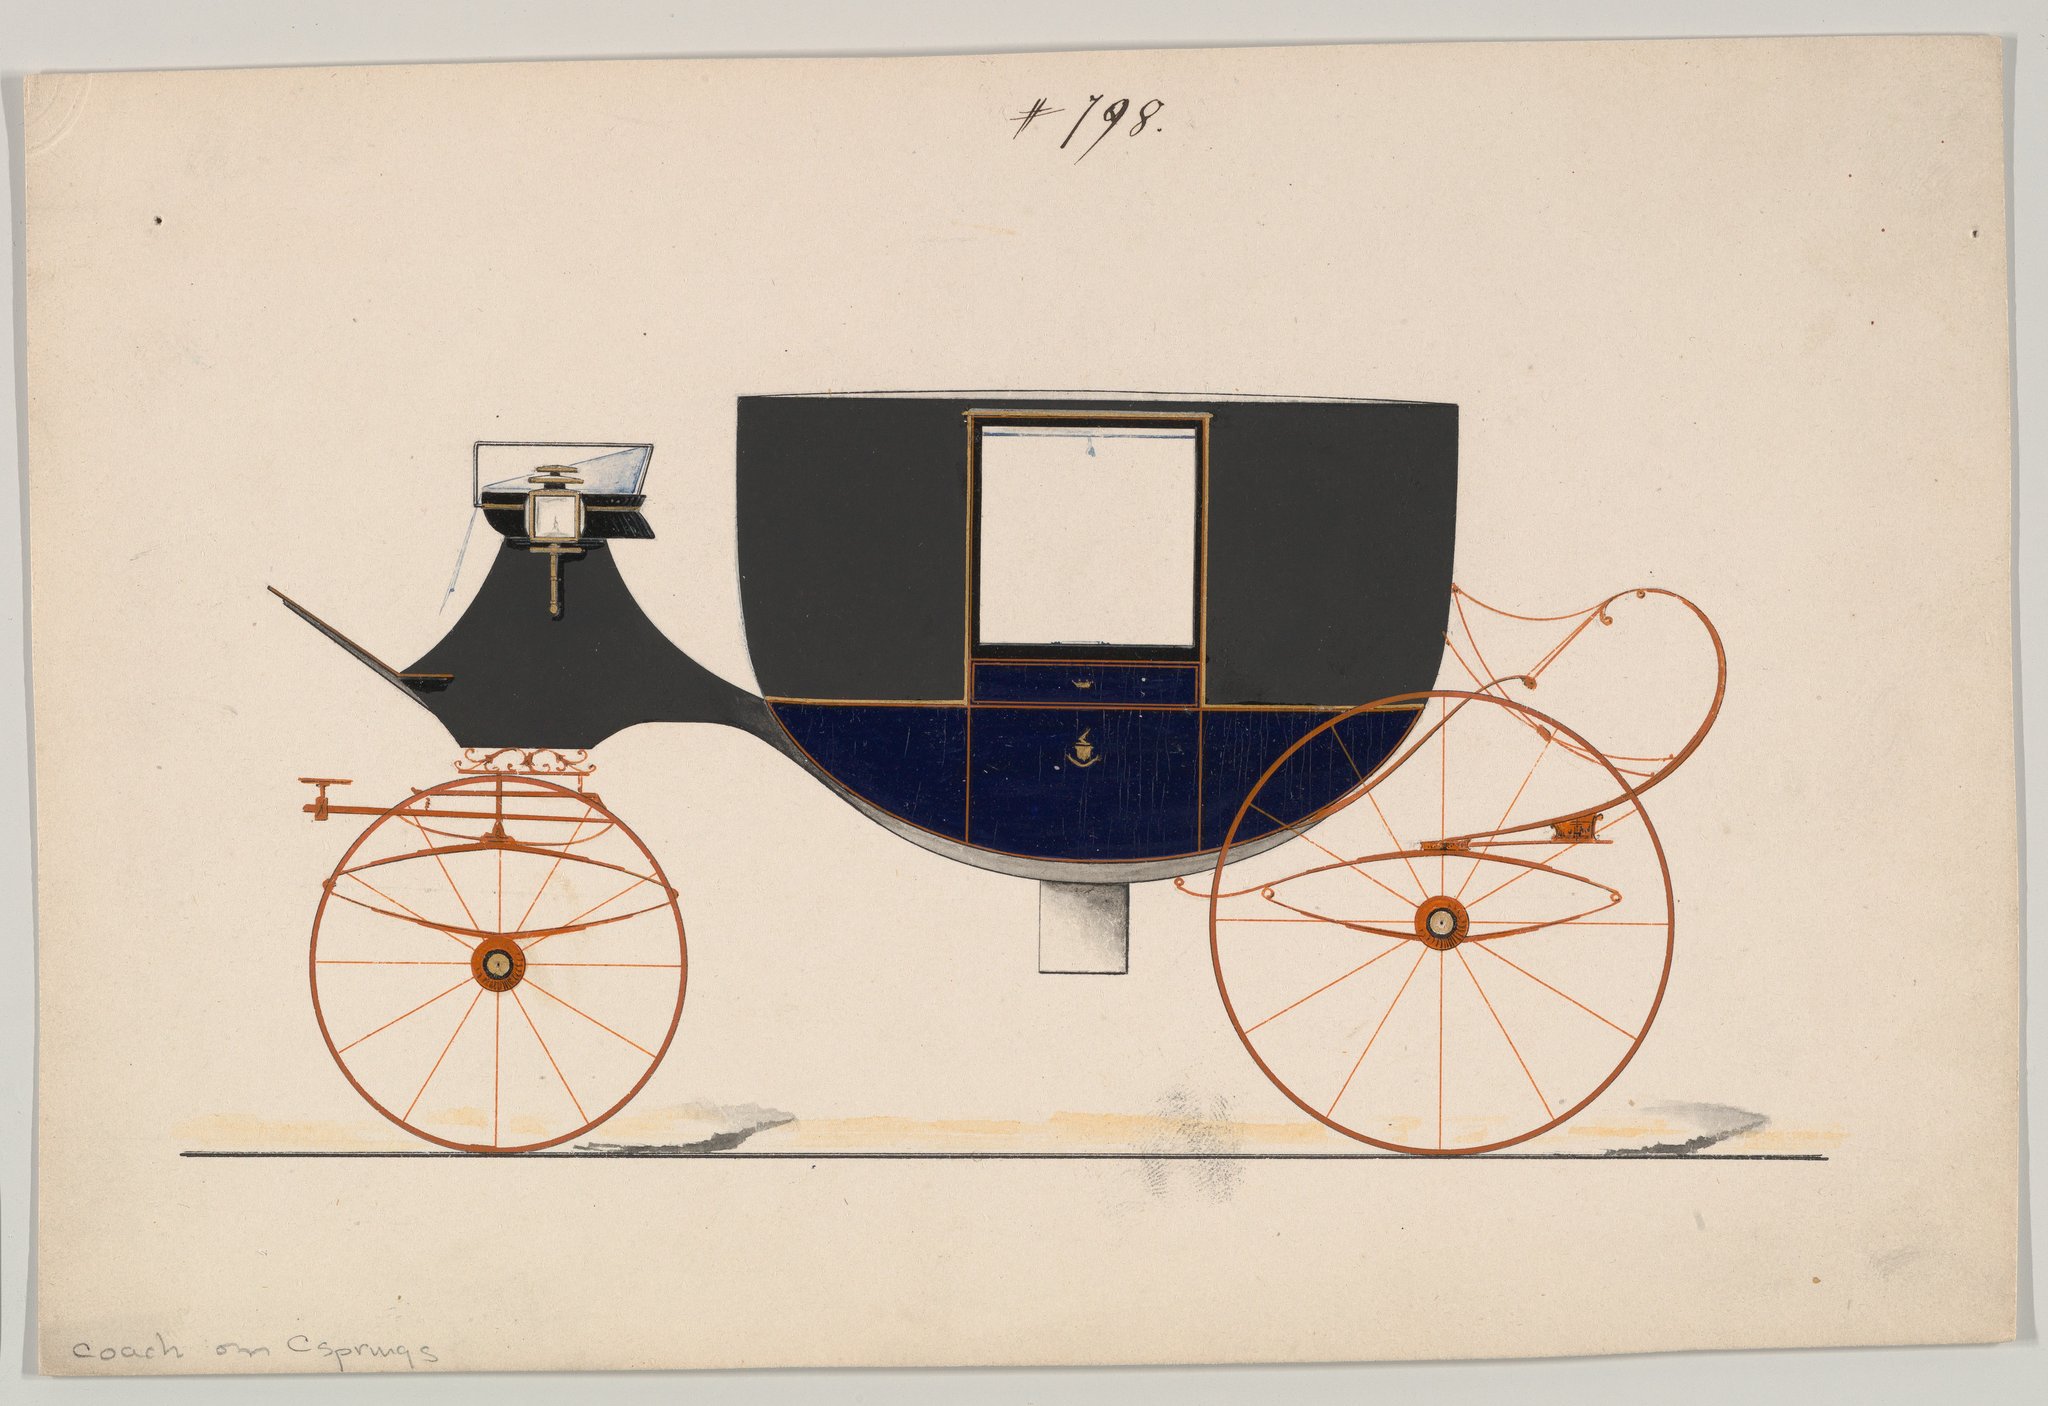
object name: drawing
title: Coach #798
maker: brewster & co.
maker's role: manufacturer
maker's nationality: american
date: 1870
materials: gouache, gum arabic, ink, watercolor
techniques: pen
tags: carriages